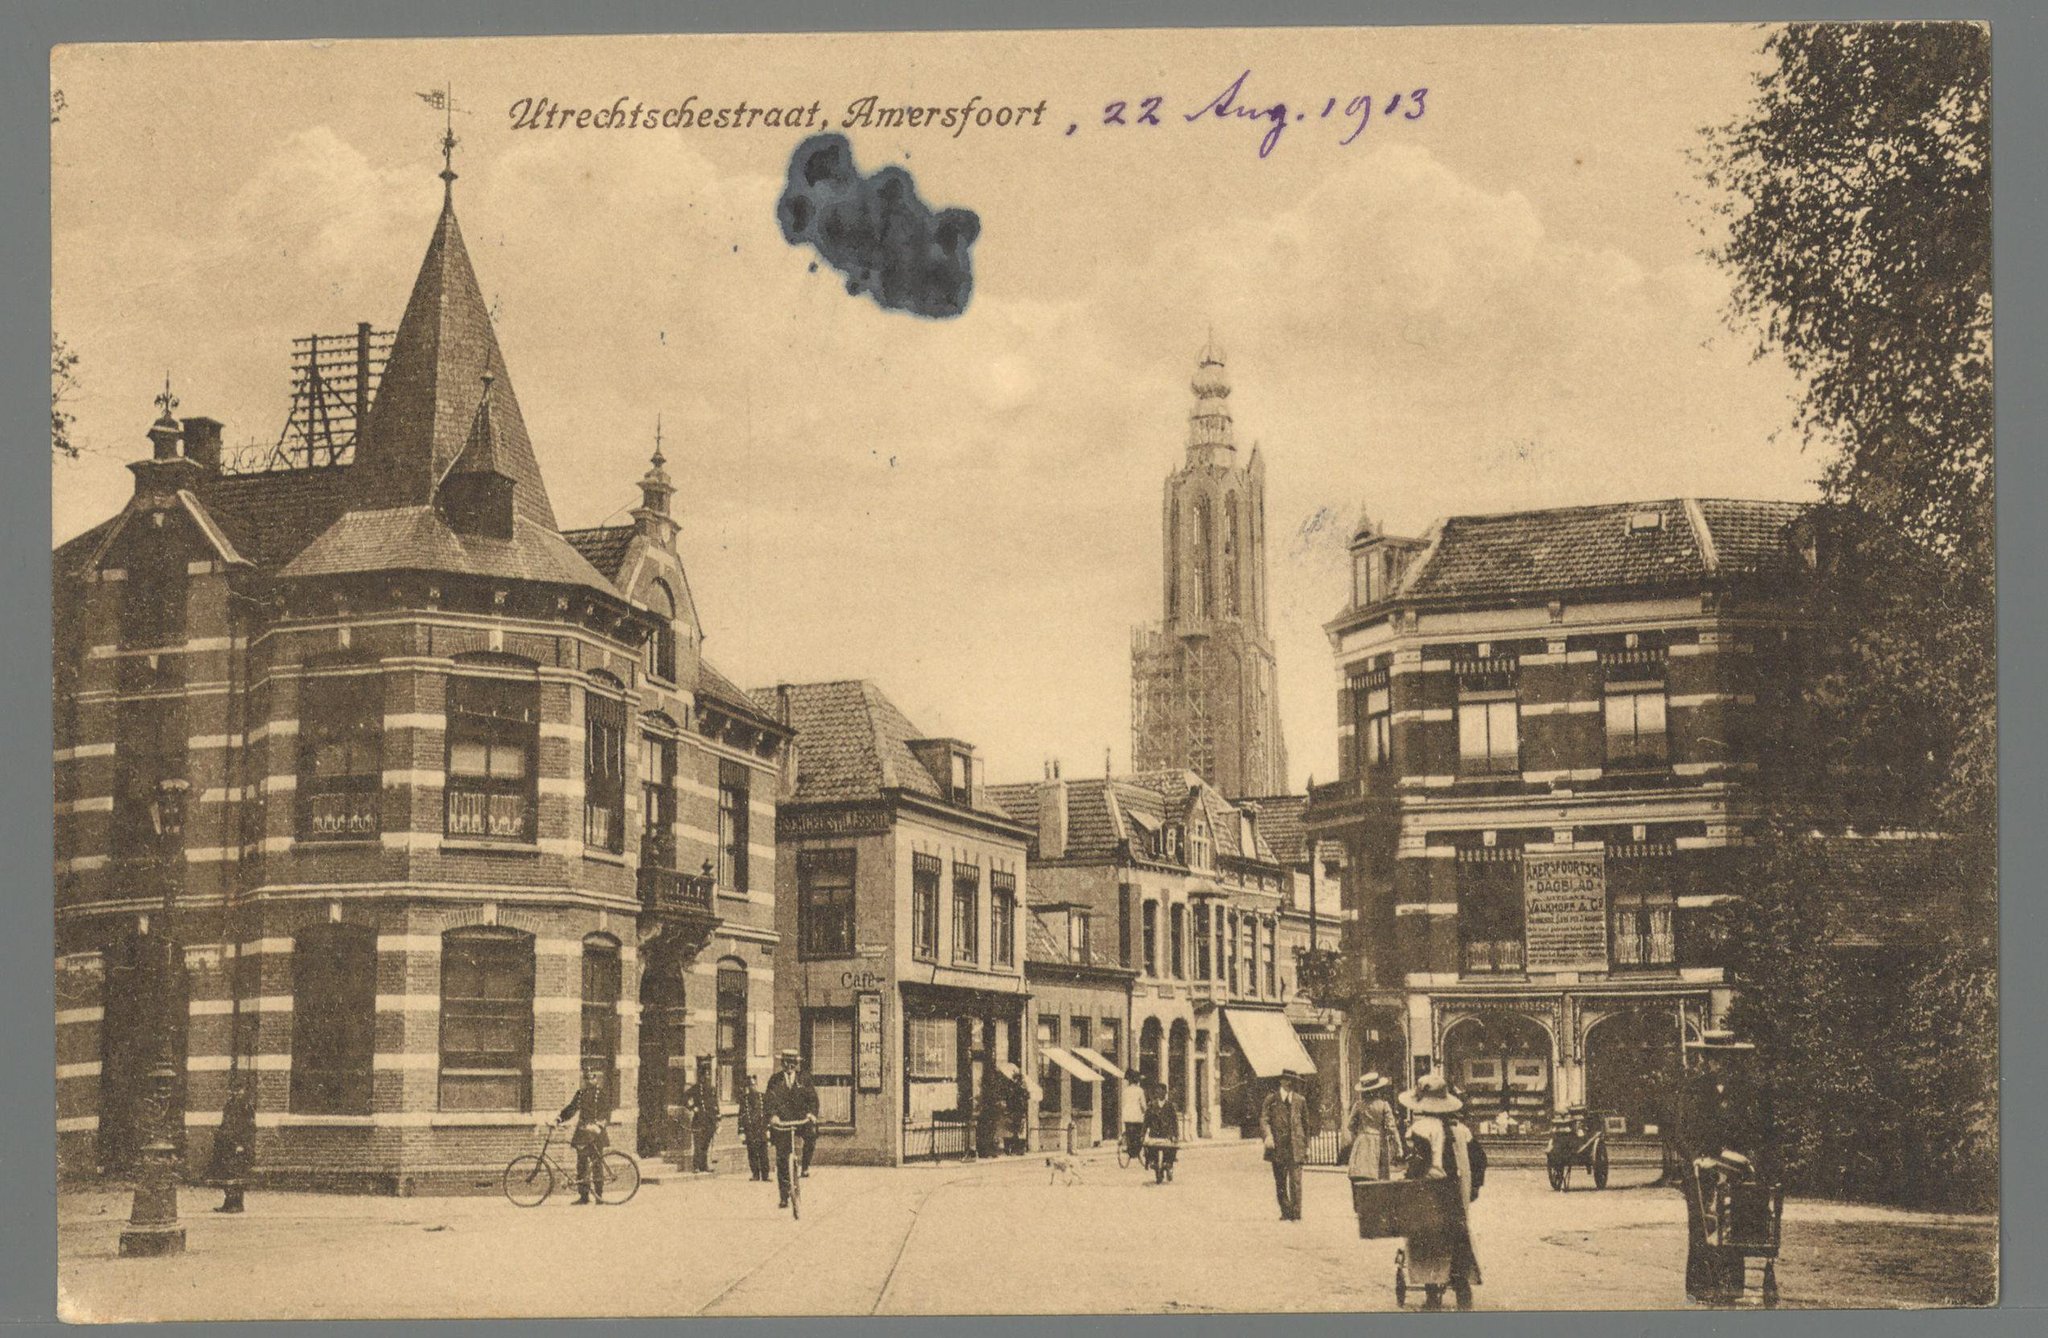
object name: ansichtkaart, prentbriefkaart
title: Utrechtschestraat, Amersfoort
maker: Anonymous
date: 1905-1913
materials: cardboard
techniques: photograph, writing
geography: amersfoort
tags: street, parts of church exterior and annexes: tower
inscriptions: postage stamp